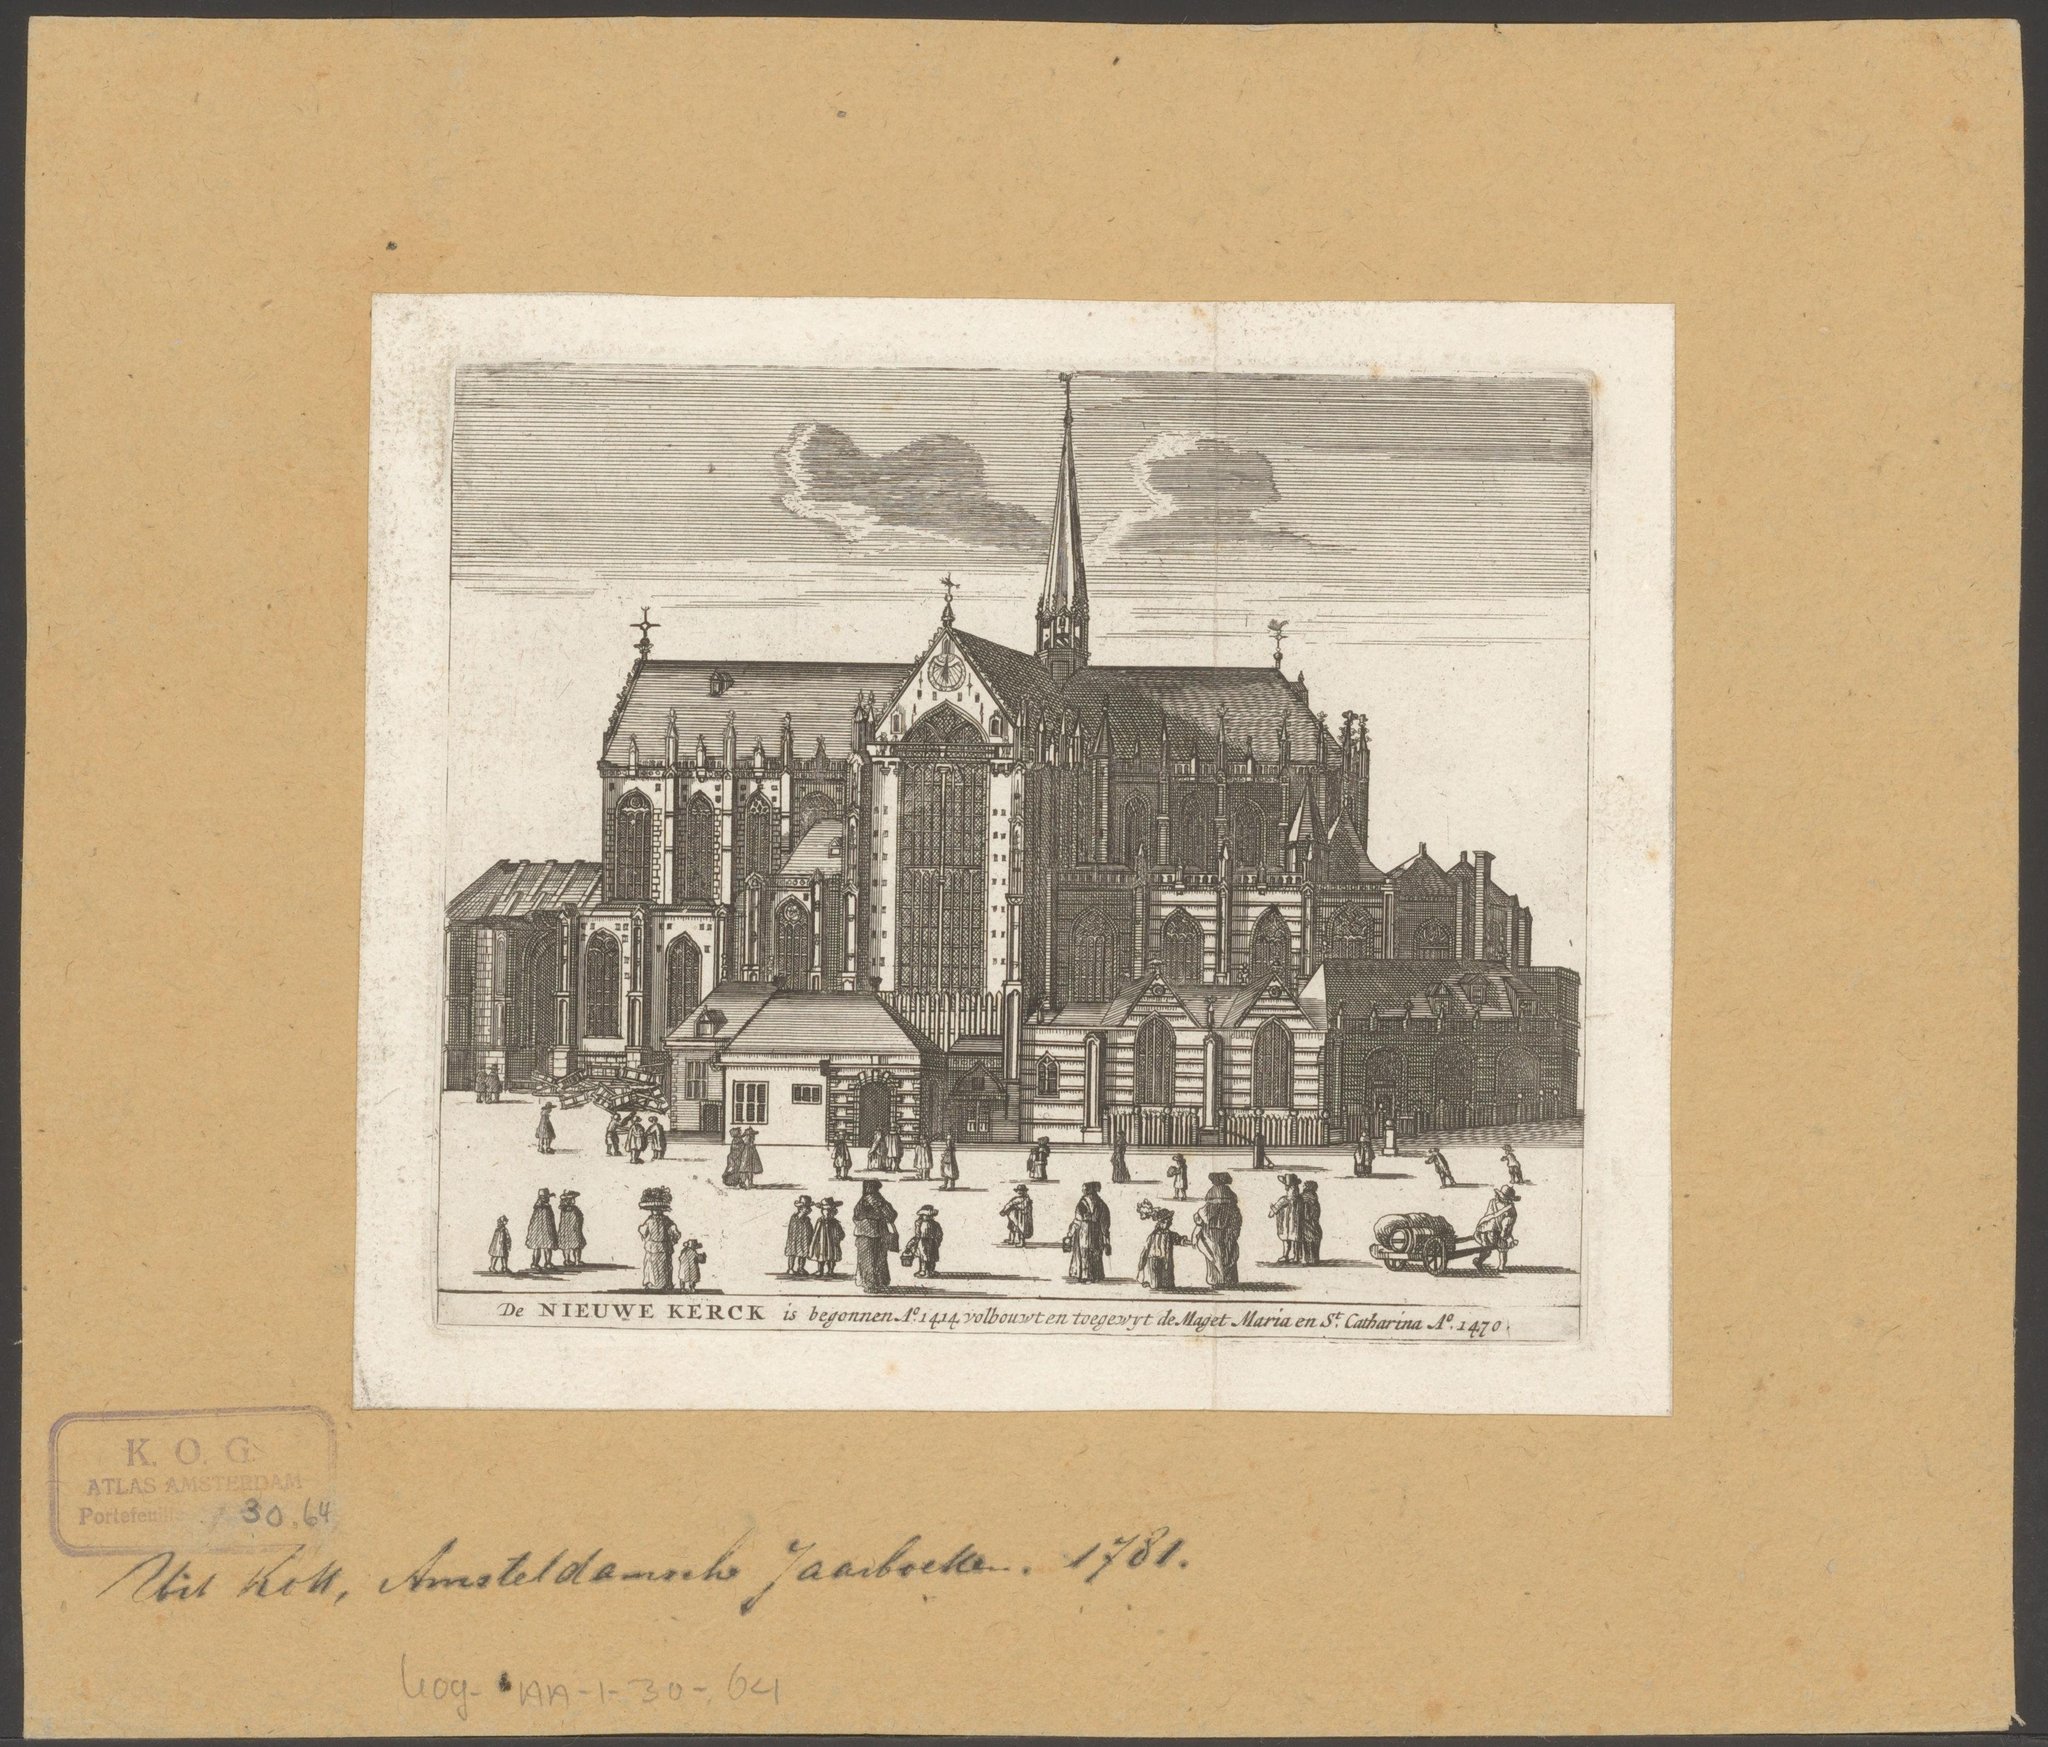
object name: print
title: De Nieuwe Kerck is begonnen Ao. 1414 volbouwt en toegewyt de Maget Maria en St. Catharina Ao. 1470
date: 1781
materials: paper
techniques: engraving, etching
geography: amsterdam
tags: church (exterior), square, place, circus, etc. (+ city(-scape) with figures, staffage)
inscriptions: collector's mark: Lugt 1641b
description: Prent mogelijk uit: Kok, Jacobus. Amsteldamsche jaarboeken, behelzende de merkwaardigste geschiedenissen (...). Amsterdam: Jan Barend Elwe, 1781, dl. 1.